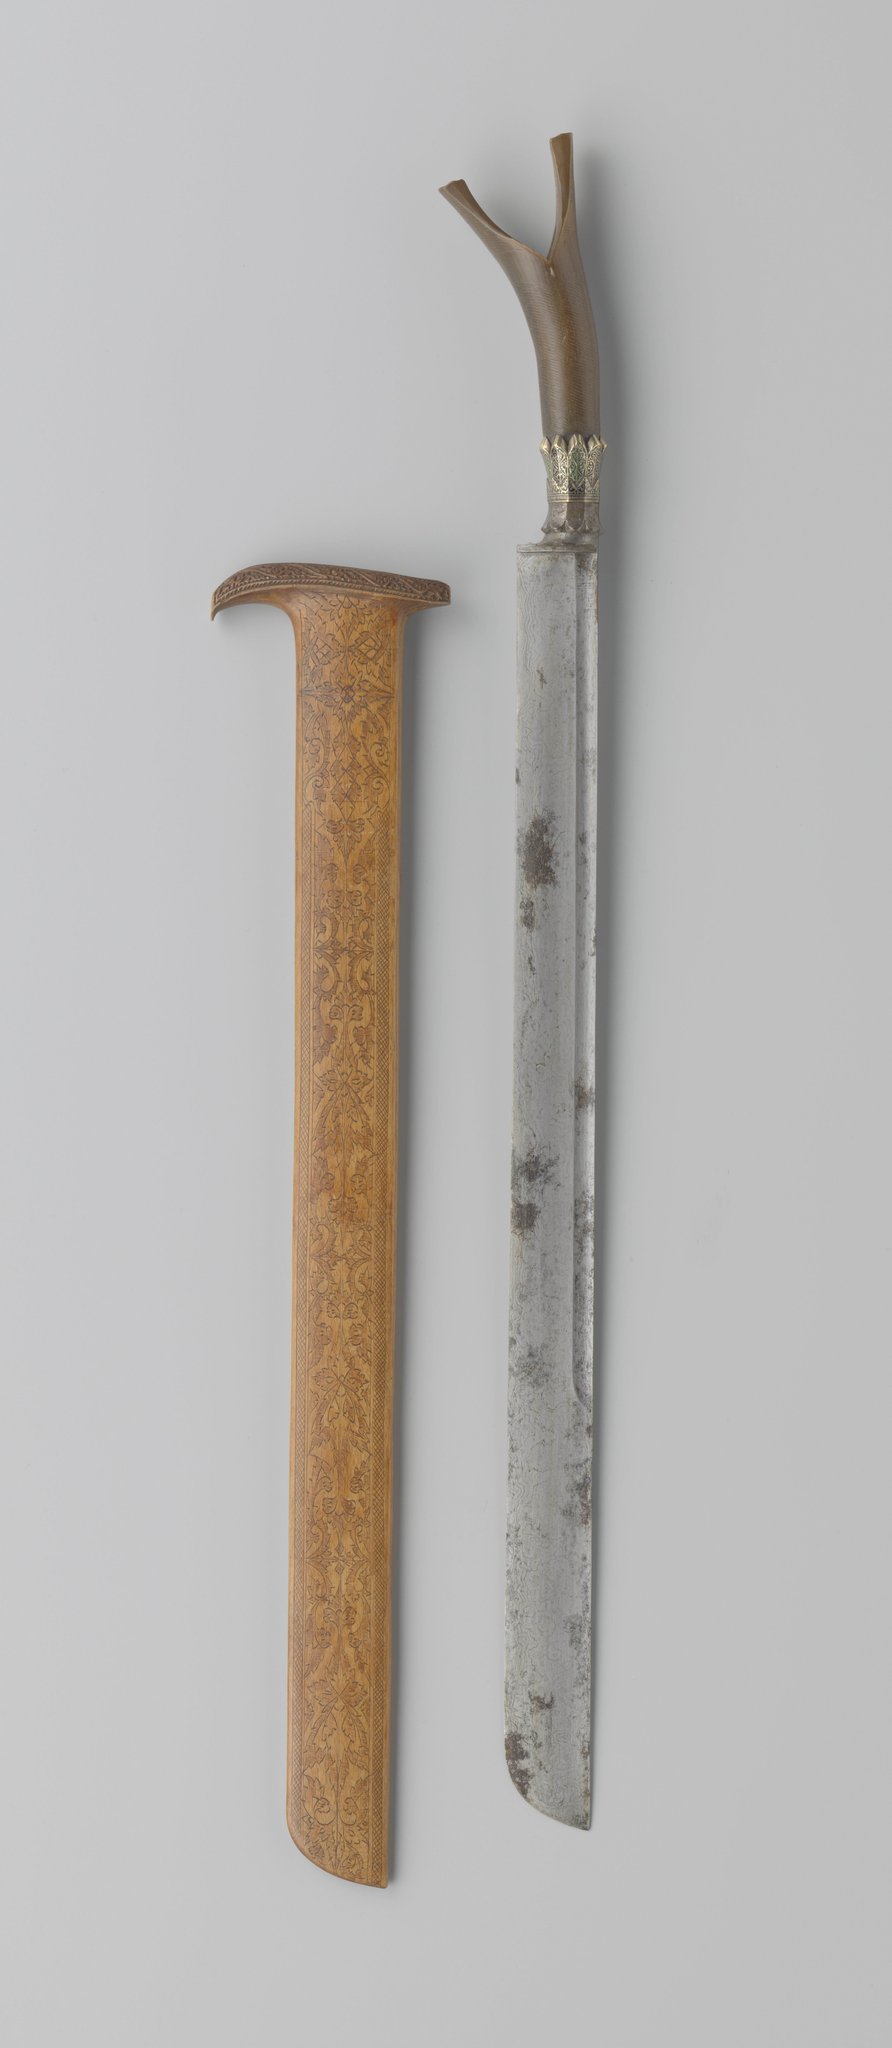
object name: hilted weapon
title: Sikin panjang met schede uit het bezit van generaal G.C.E. van Daalen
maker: Anonymous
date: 1700-1950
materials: horn, iron, wood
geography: north sumatra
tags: sumatra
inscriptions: number: ‘4373’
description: De sikin panjang heeft een bijbehorende schede. De kling van het wapen is geheel recht waarbij de schede en de rug evenwijdig aan elkaar lopen. Vlakbij de punt buigt de snede schuin af naar de rug. Langs de rug loopt tot ongeveer tweederde van het lemmet aan beide zijden een brede, vrij ondiepe groef. De doorsnede van het lemmet is wigvormig, met iets holle zijden. De rug wordt naar de punt toe geleidelijk aan iets smaller. Bij de greep bevindt zich een steelring die met de kling uit één stuk is gesmeed. De steelring heeft acht of negen hoeken (kelkbladen). De kling is gedamasceerd. De greep is gevorkt. De greep is gemaakt van hoorn van de karbouw en voorzien van een eenvoudig groevenpatroon. De schede is gedecoreerd met natuurlijke en bloemmotieven.